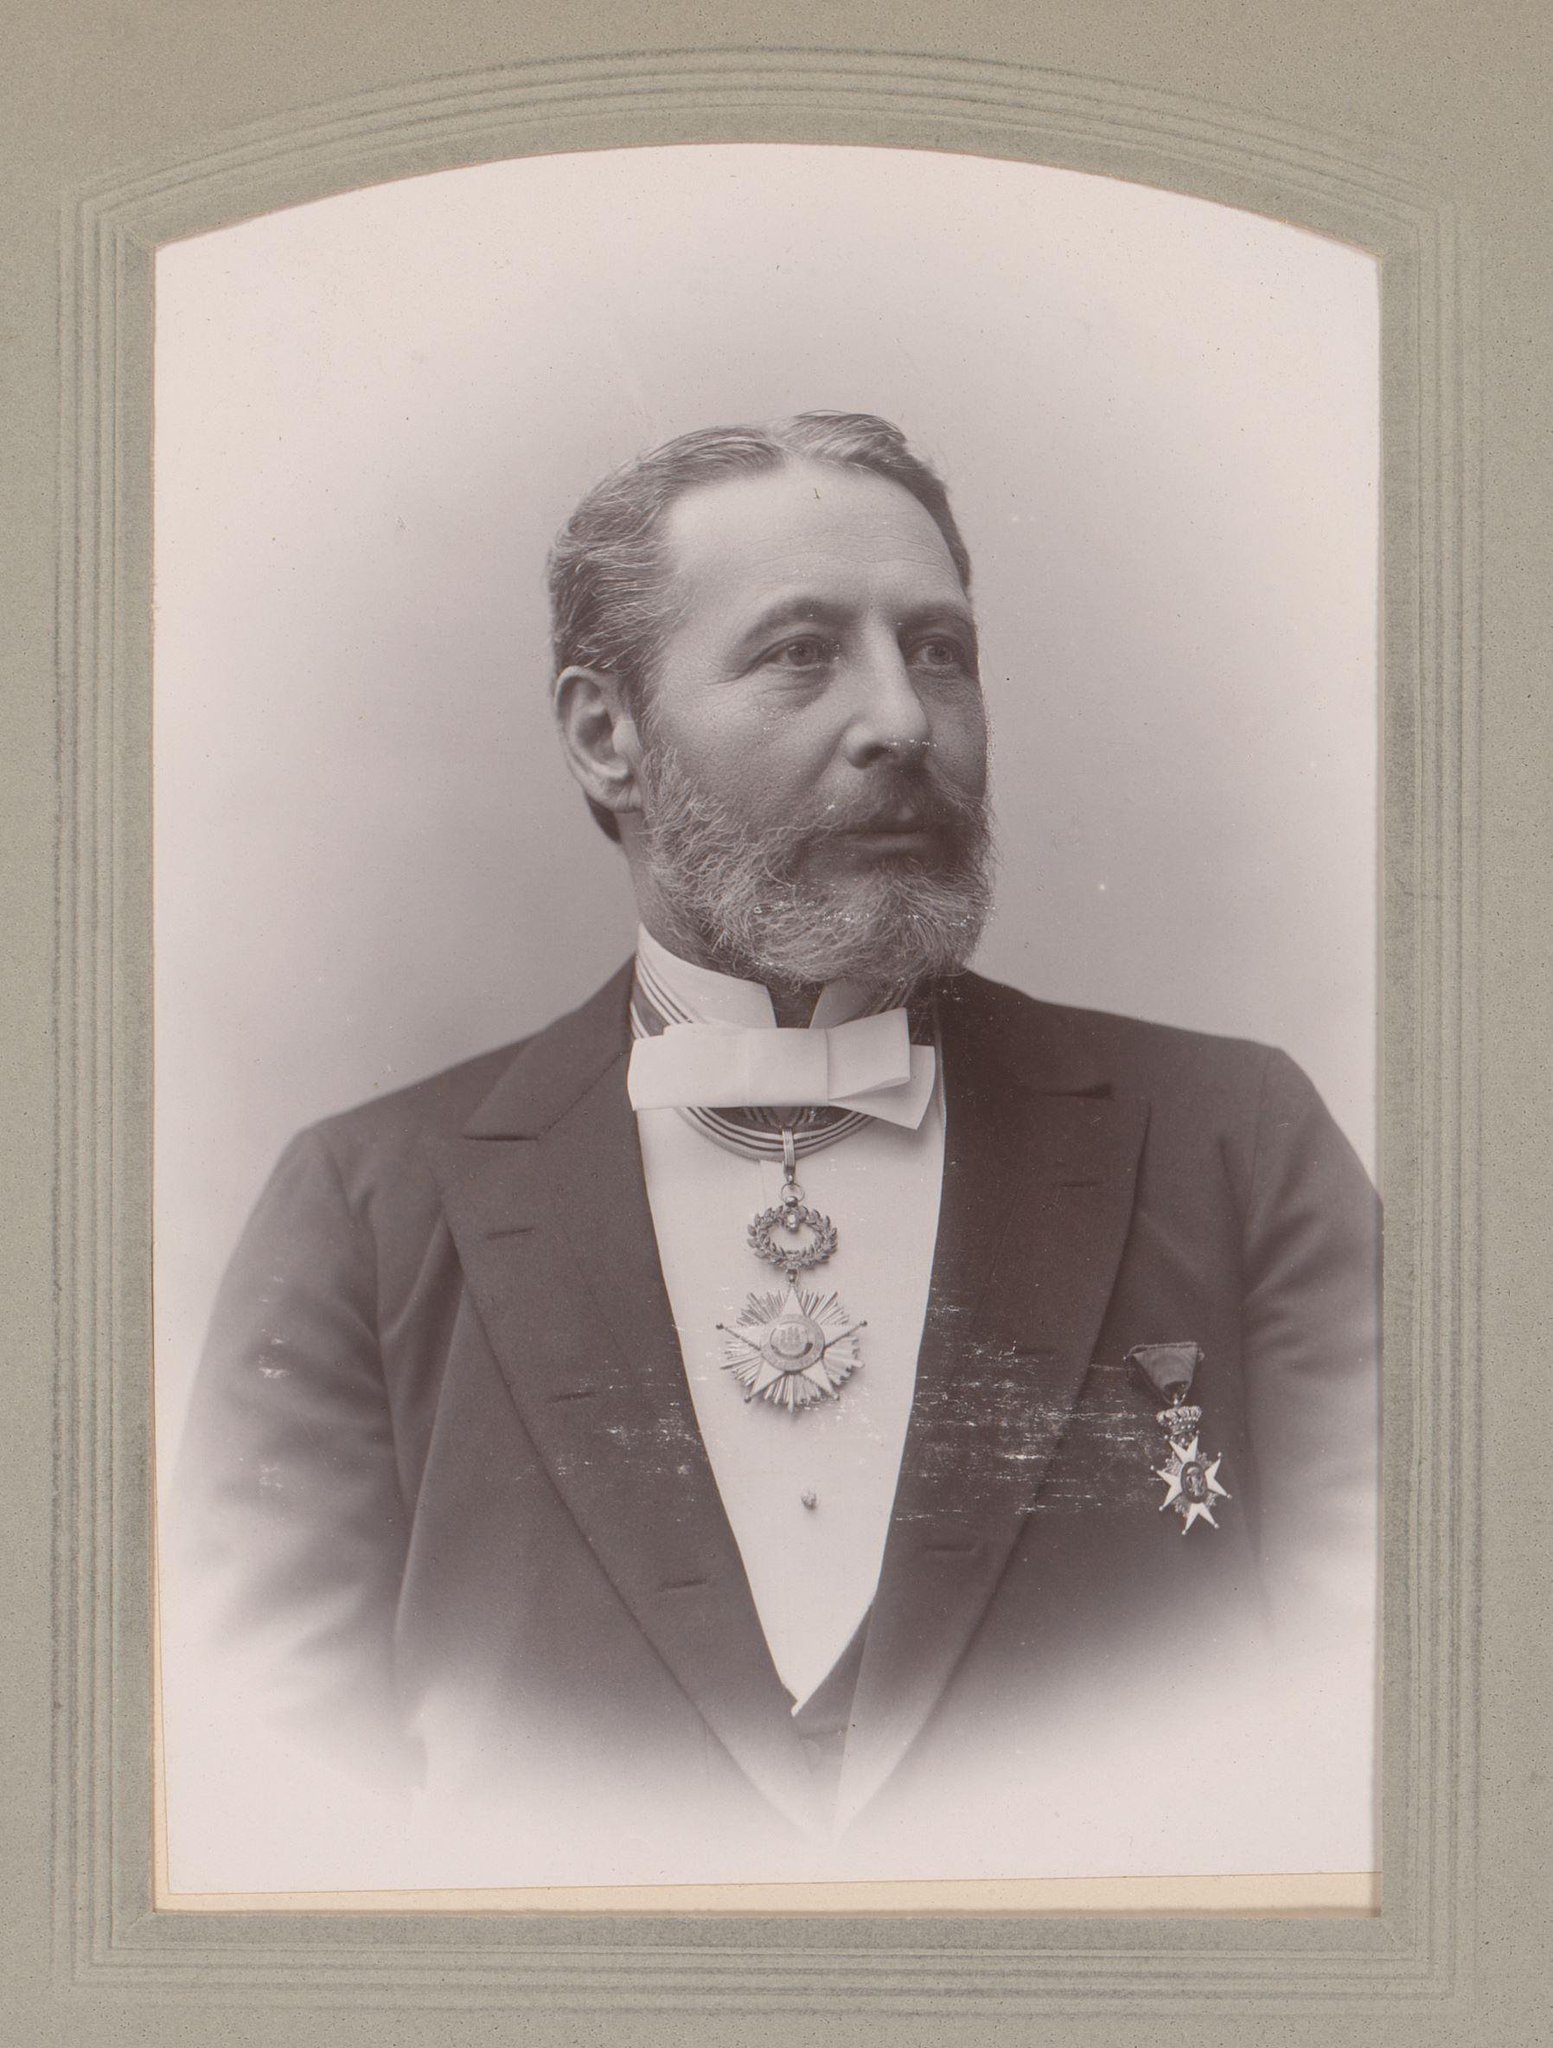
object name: album leaf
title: Portret van een man met vlinderstrik en twee insignes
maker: gustaf alfred johanson dahllöf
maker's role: fotograaf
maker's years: 1841-1908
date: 1880-1920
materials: cardboard, photographic support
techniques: collodion silver print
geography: stockholm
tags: historical persons, medals and other marks of military honour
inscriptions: inscription: ‘Telefon No. 4454./ (...)/ Alfr Json Dahhlöf/ Stockholm/ 47, Drottninggatan 47,/ (hörnet af Mästersamuelsgatan)/ Plåten förvaras för efterbeställning.’